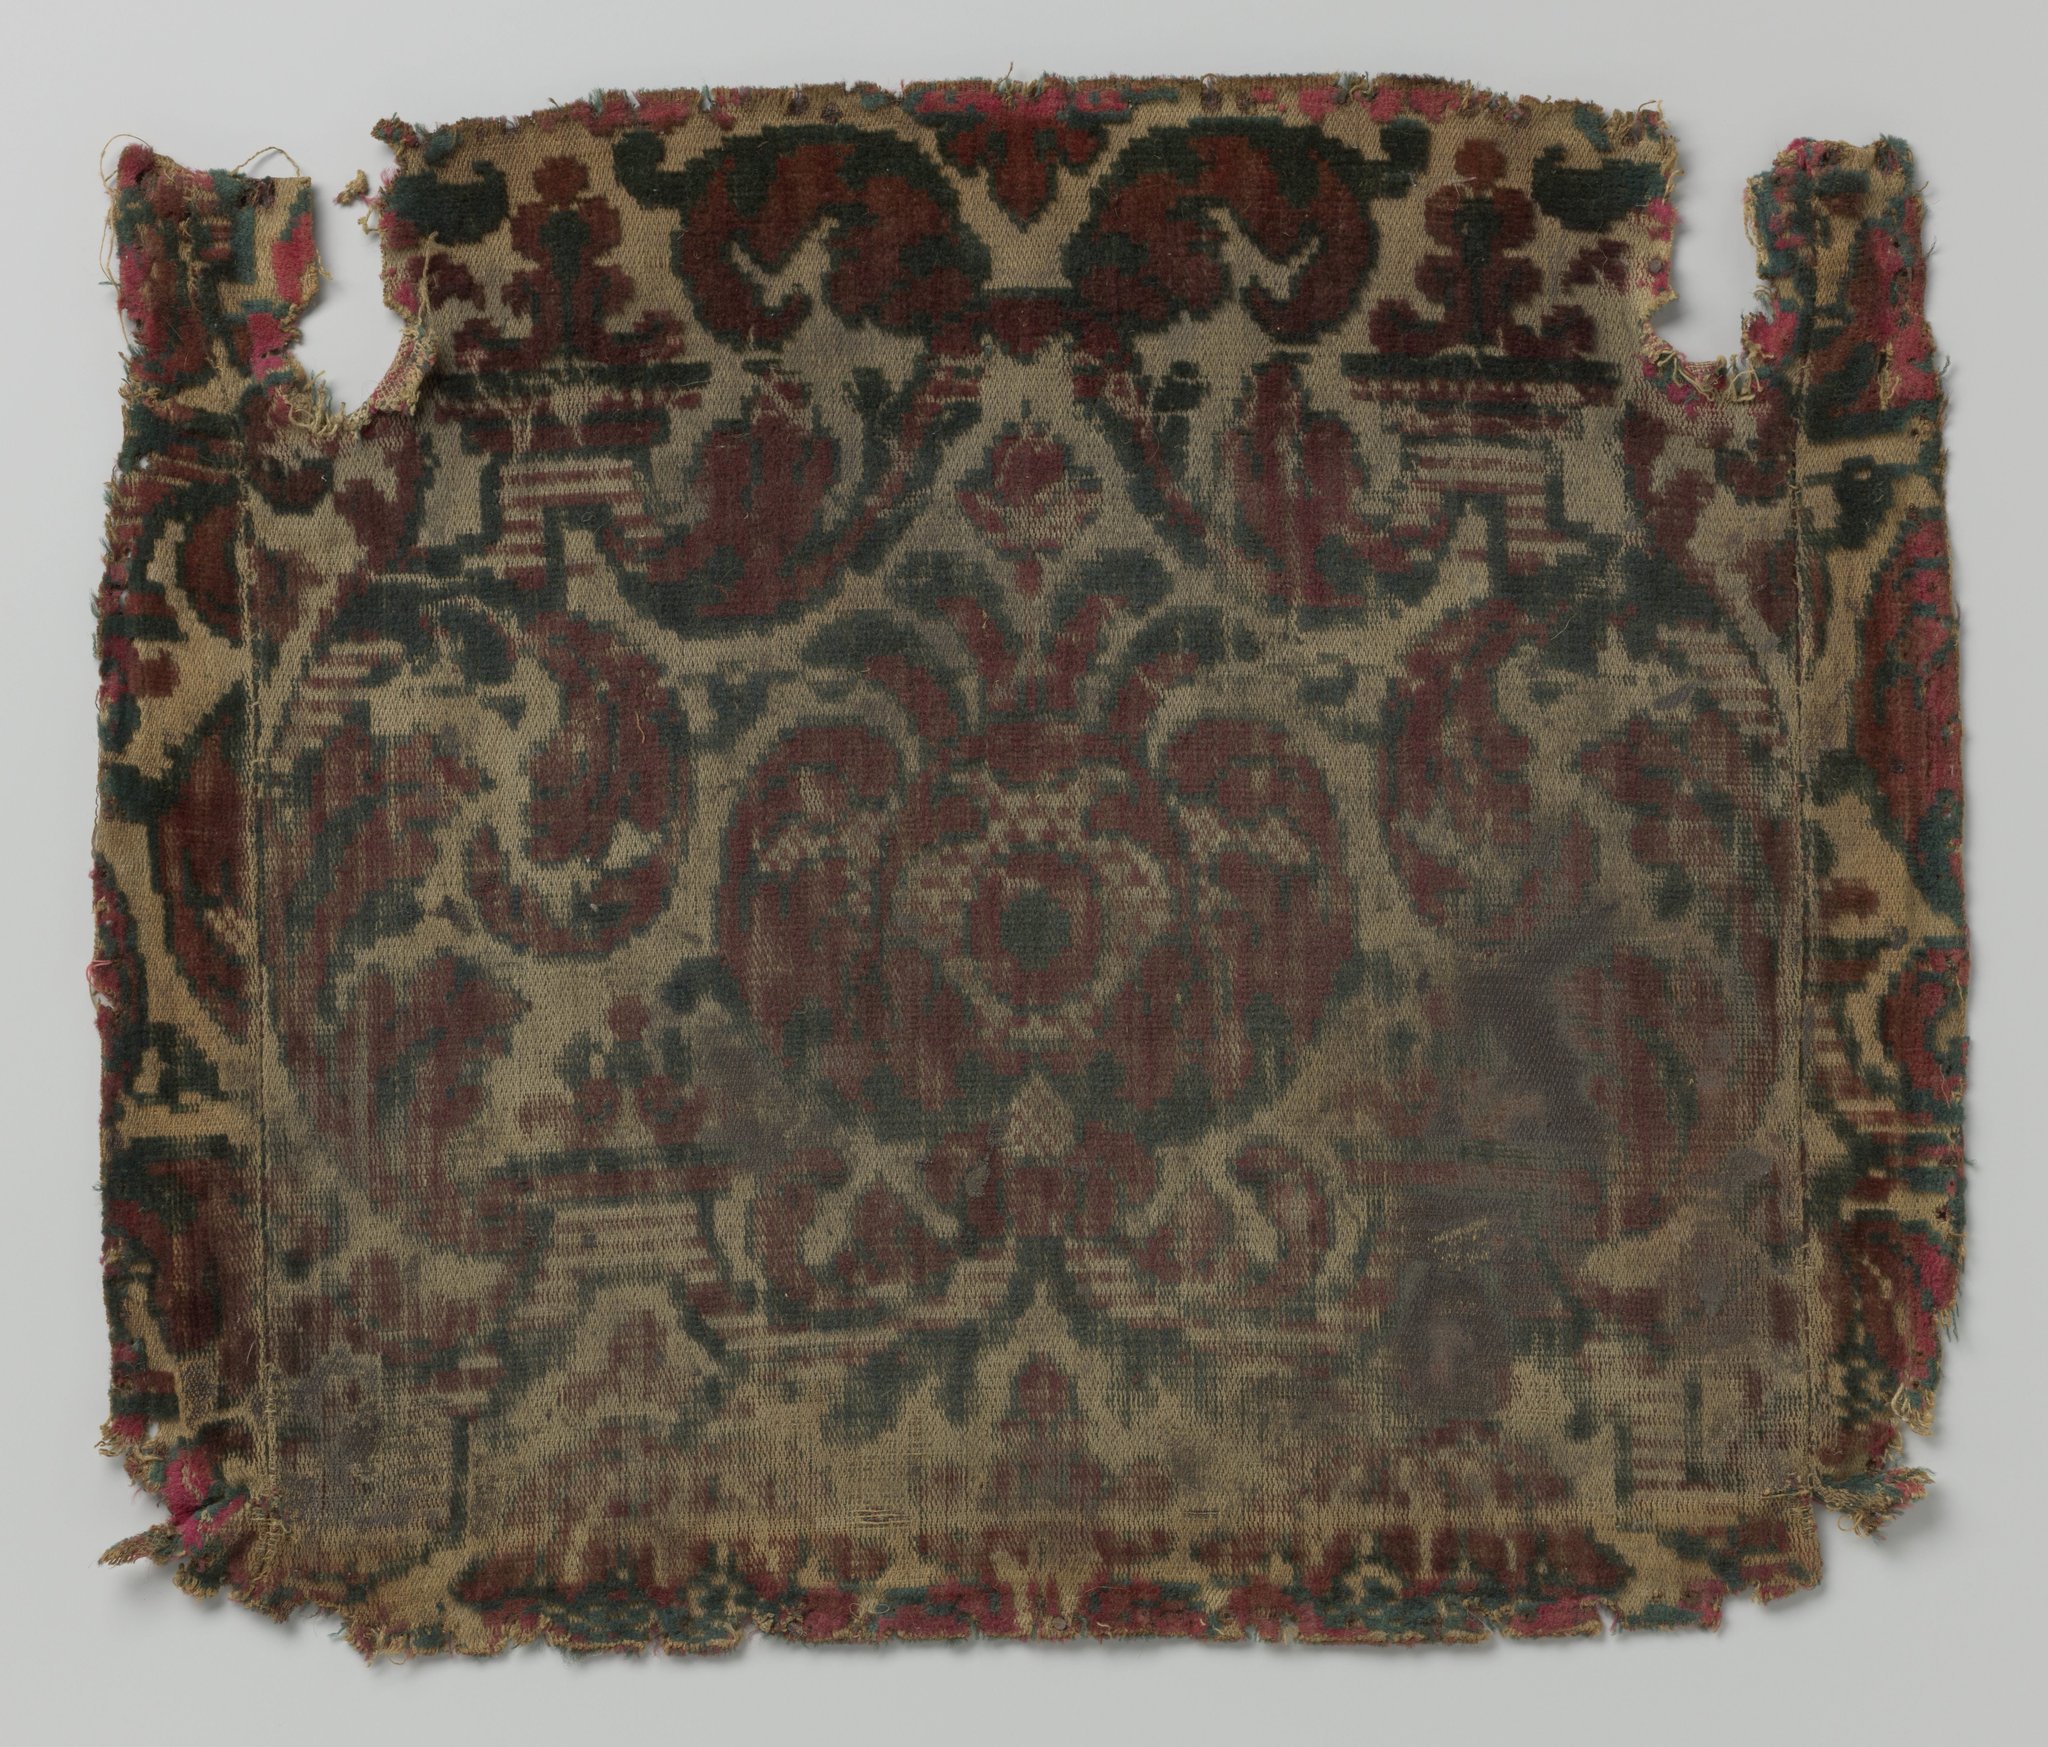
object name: stoelbekleding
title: Fragment geschoren fluweel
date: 1650-1700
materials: linen, velvet, wool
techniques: weave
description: Fragment fluweel met patroon van acanthusbladeren in de kleuren groen en blauw op crèmekleurige grond. Opmerking: fragment behoort vermoedelijk bij de stoel met inv.nr BK-KOG-1443-A.